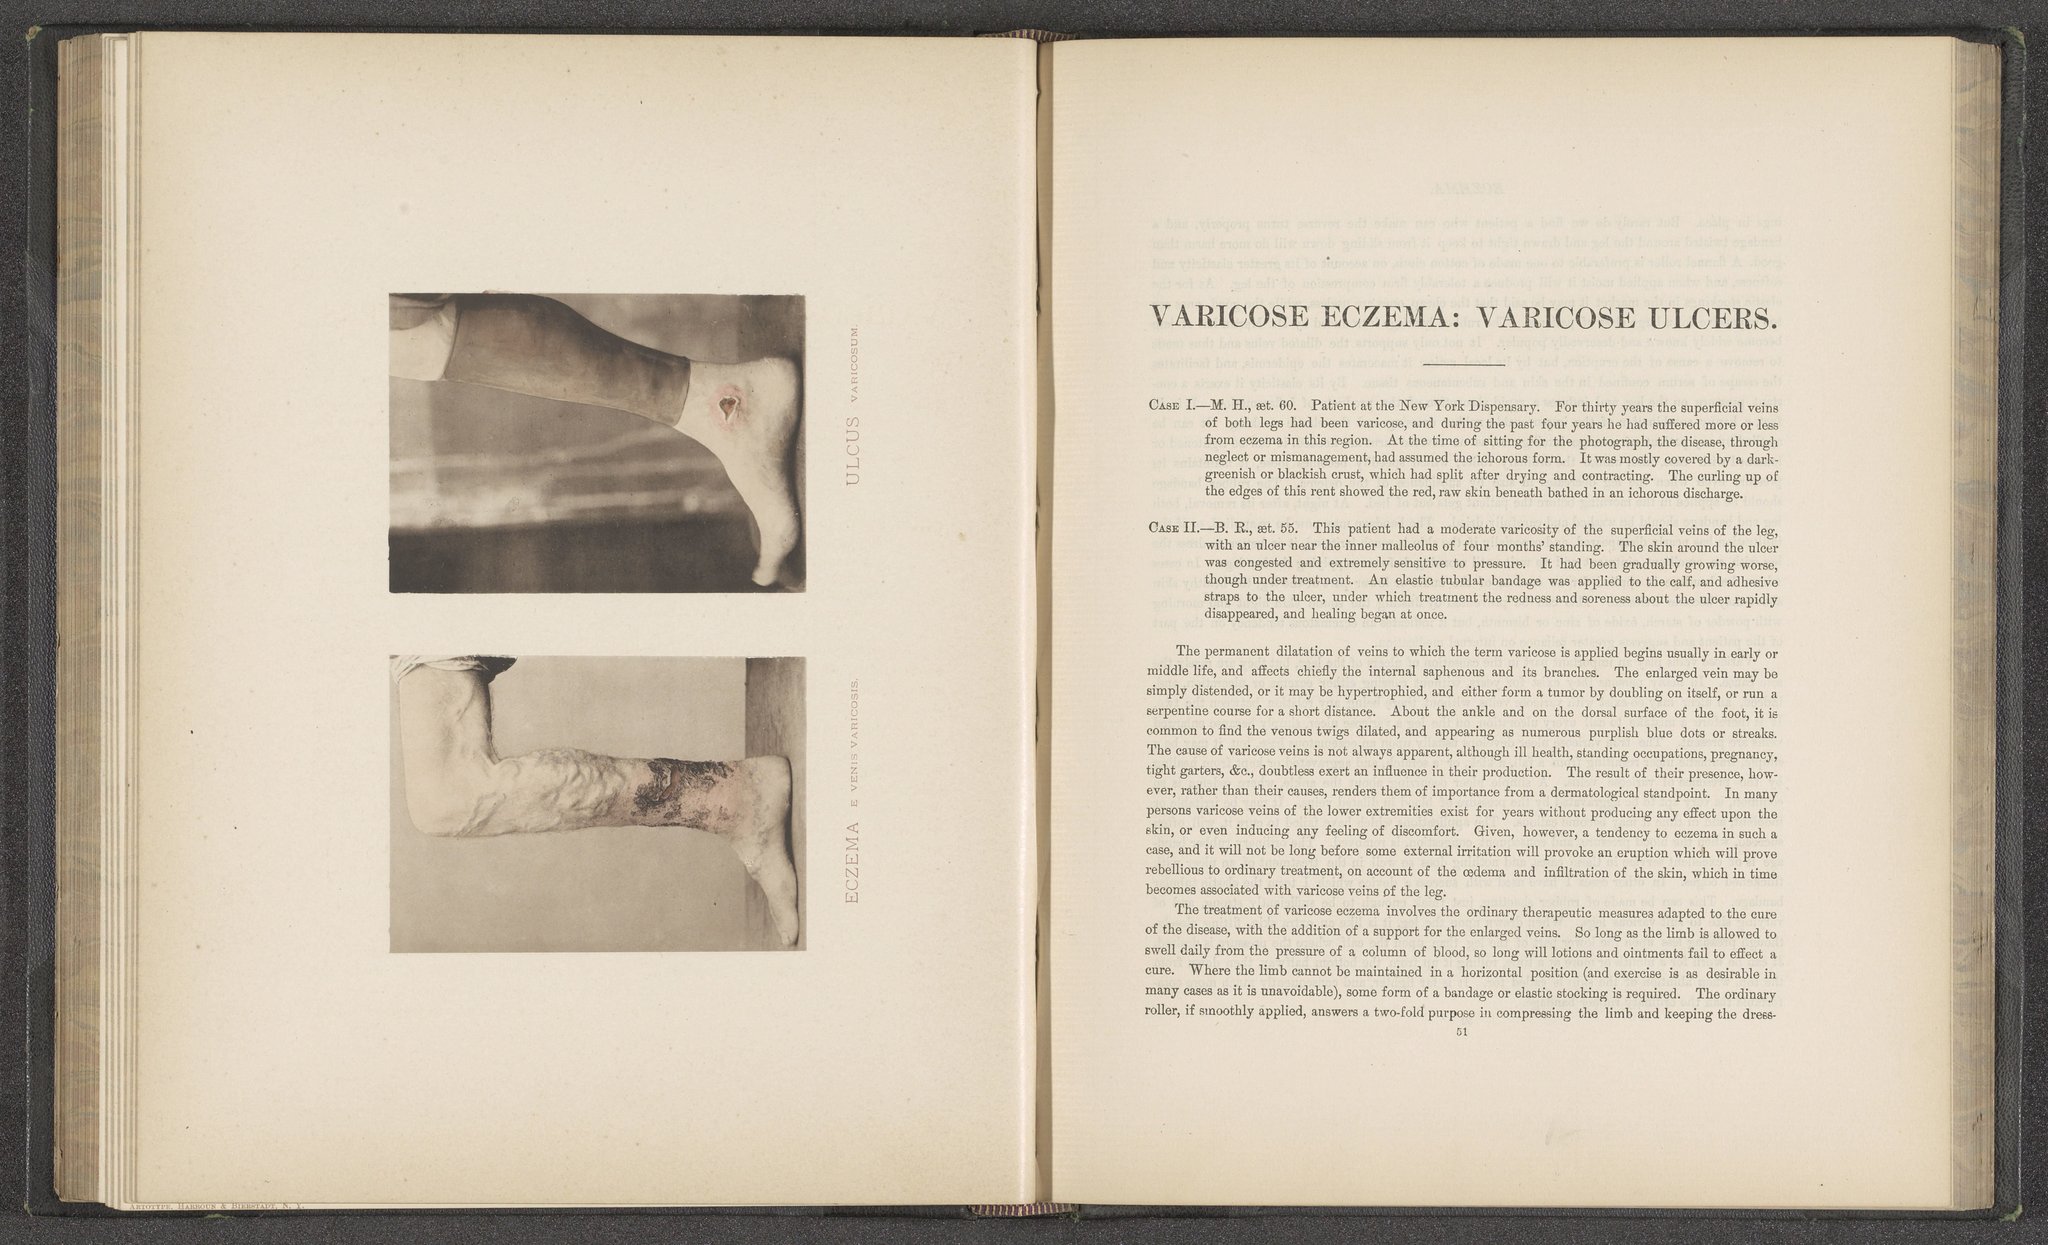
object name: photomechanical print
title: Patiënten lijdend aan de huidziekte 'eczema e venis varicosis' en 'ulcus varicosum'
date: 1870-1881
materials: paper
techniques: photograph, hand coloring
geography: new york city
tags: skin and venereal diseases, legs